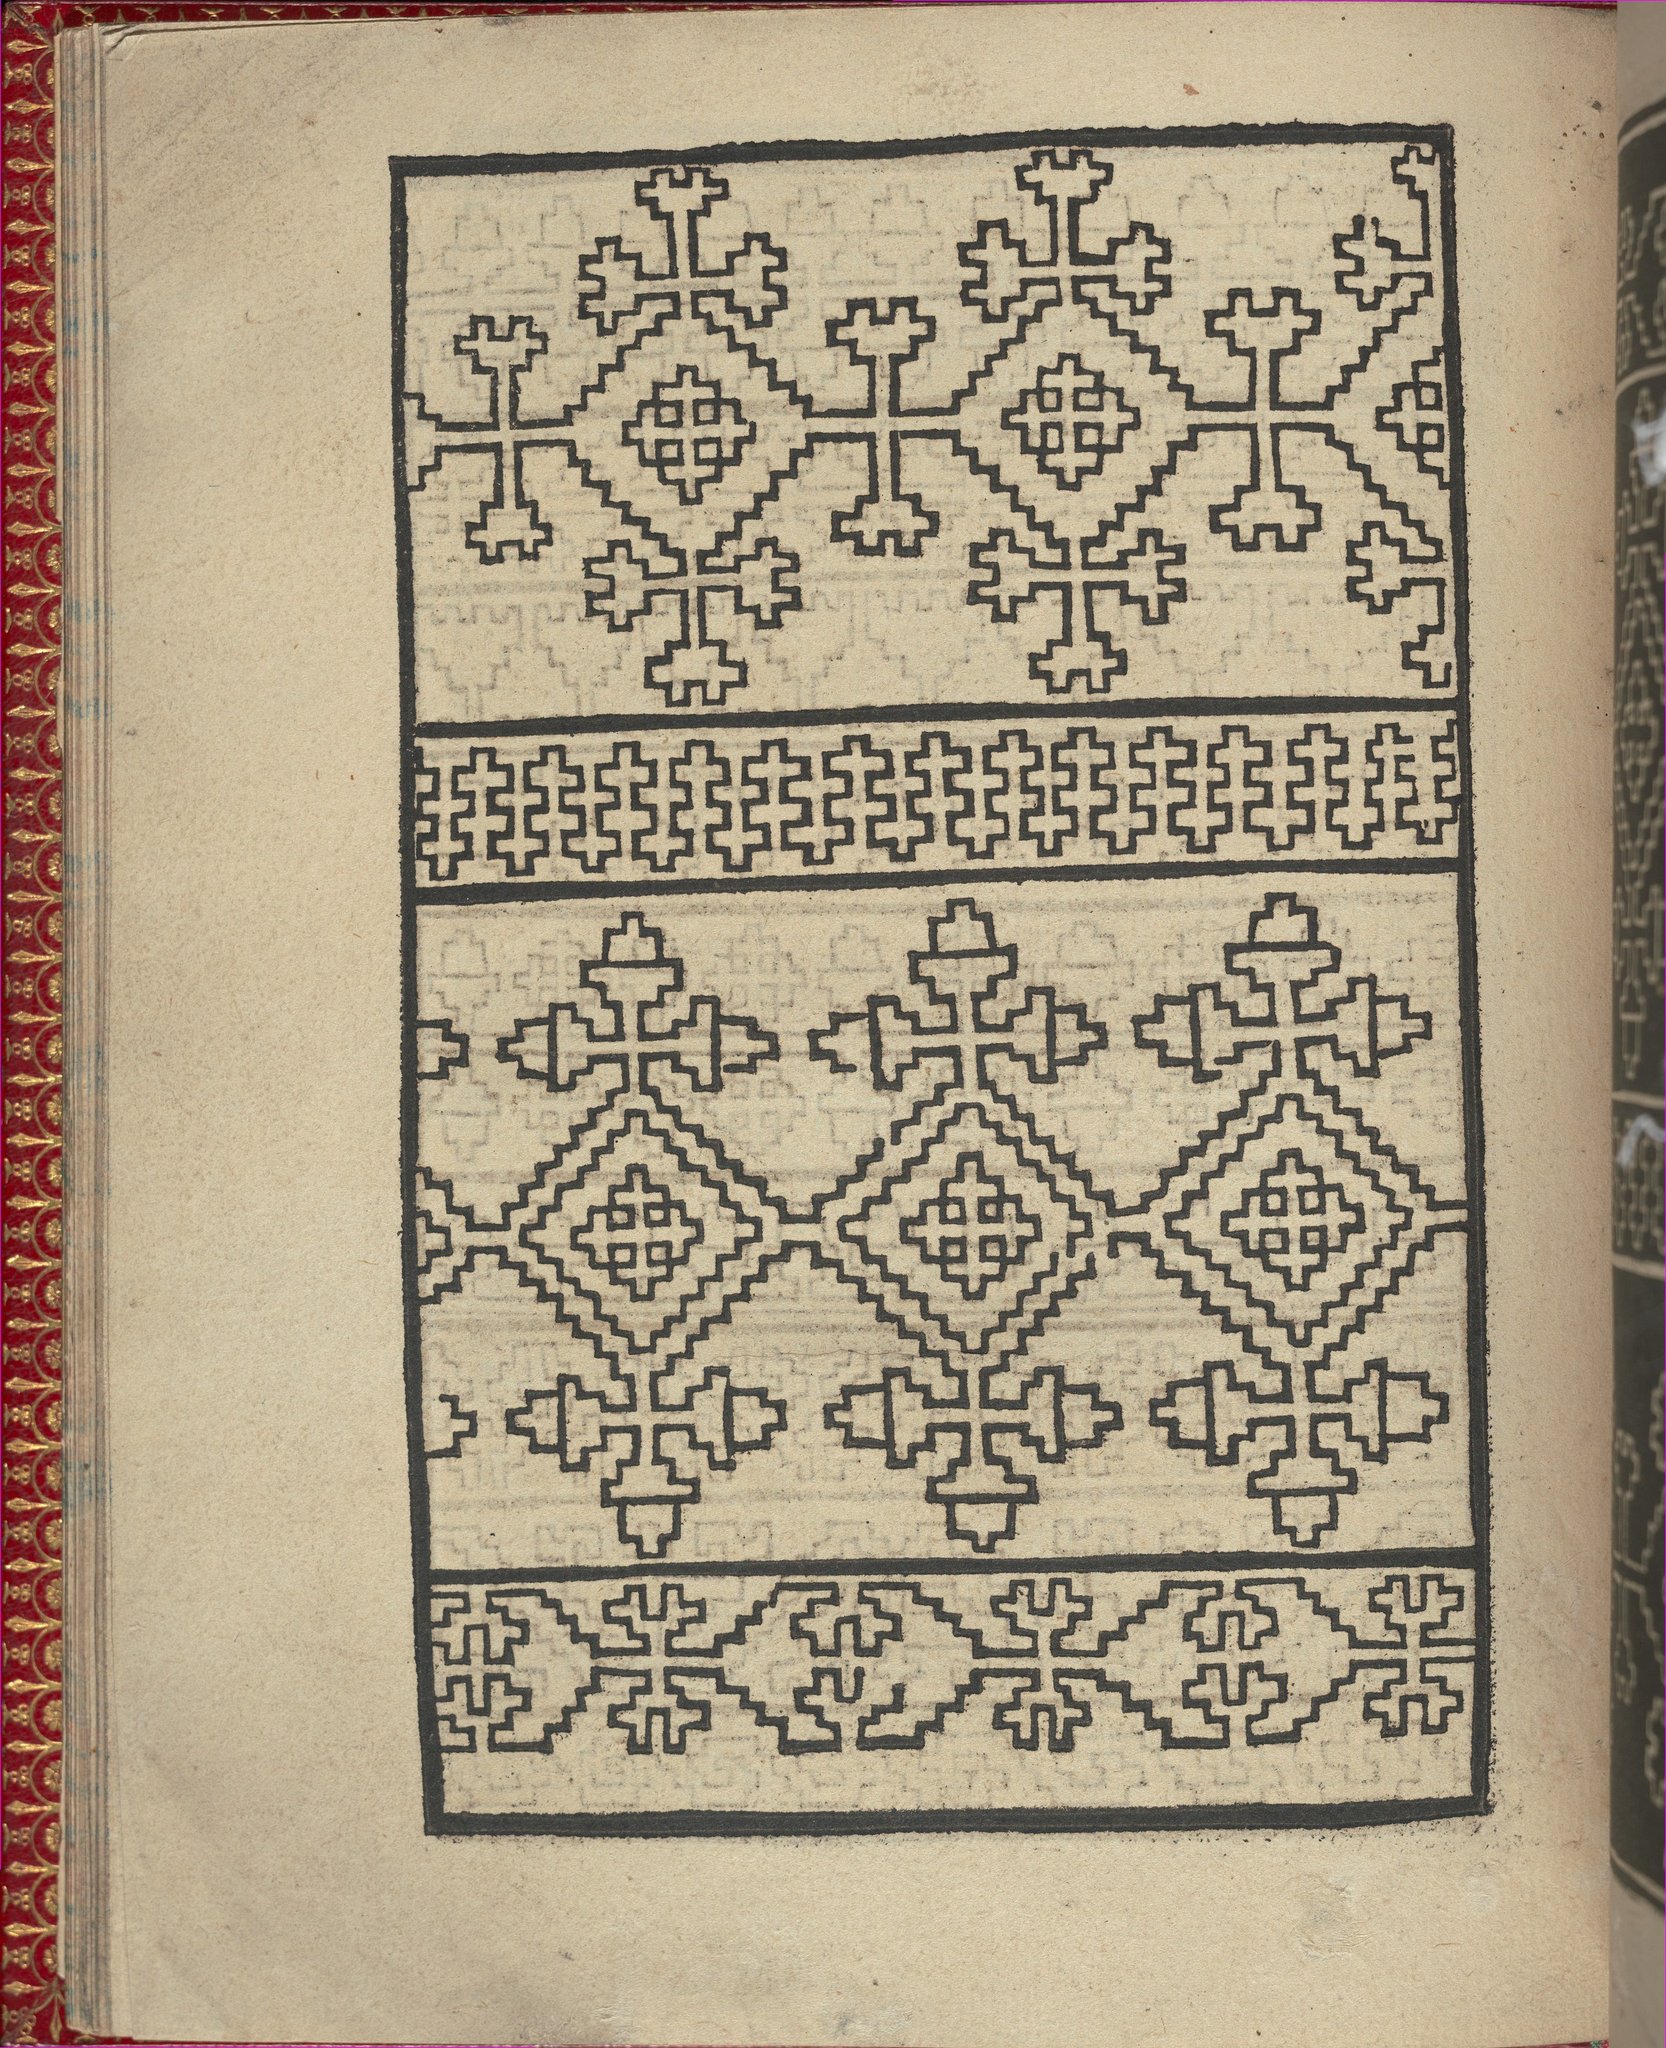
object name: book print ornament architecture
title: Ce est ung tractat de la noble art de leguille ascavoir ouvraiges de spaigne... page 20 (verso)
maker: willem vosterman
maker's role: printer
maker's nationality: netherlandish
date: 1527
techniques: woodcut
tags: ornament